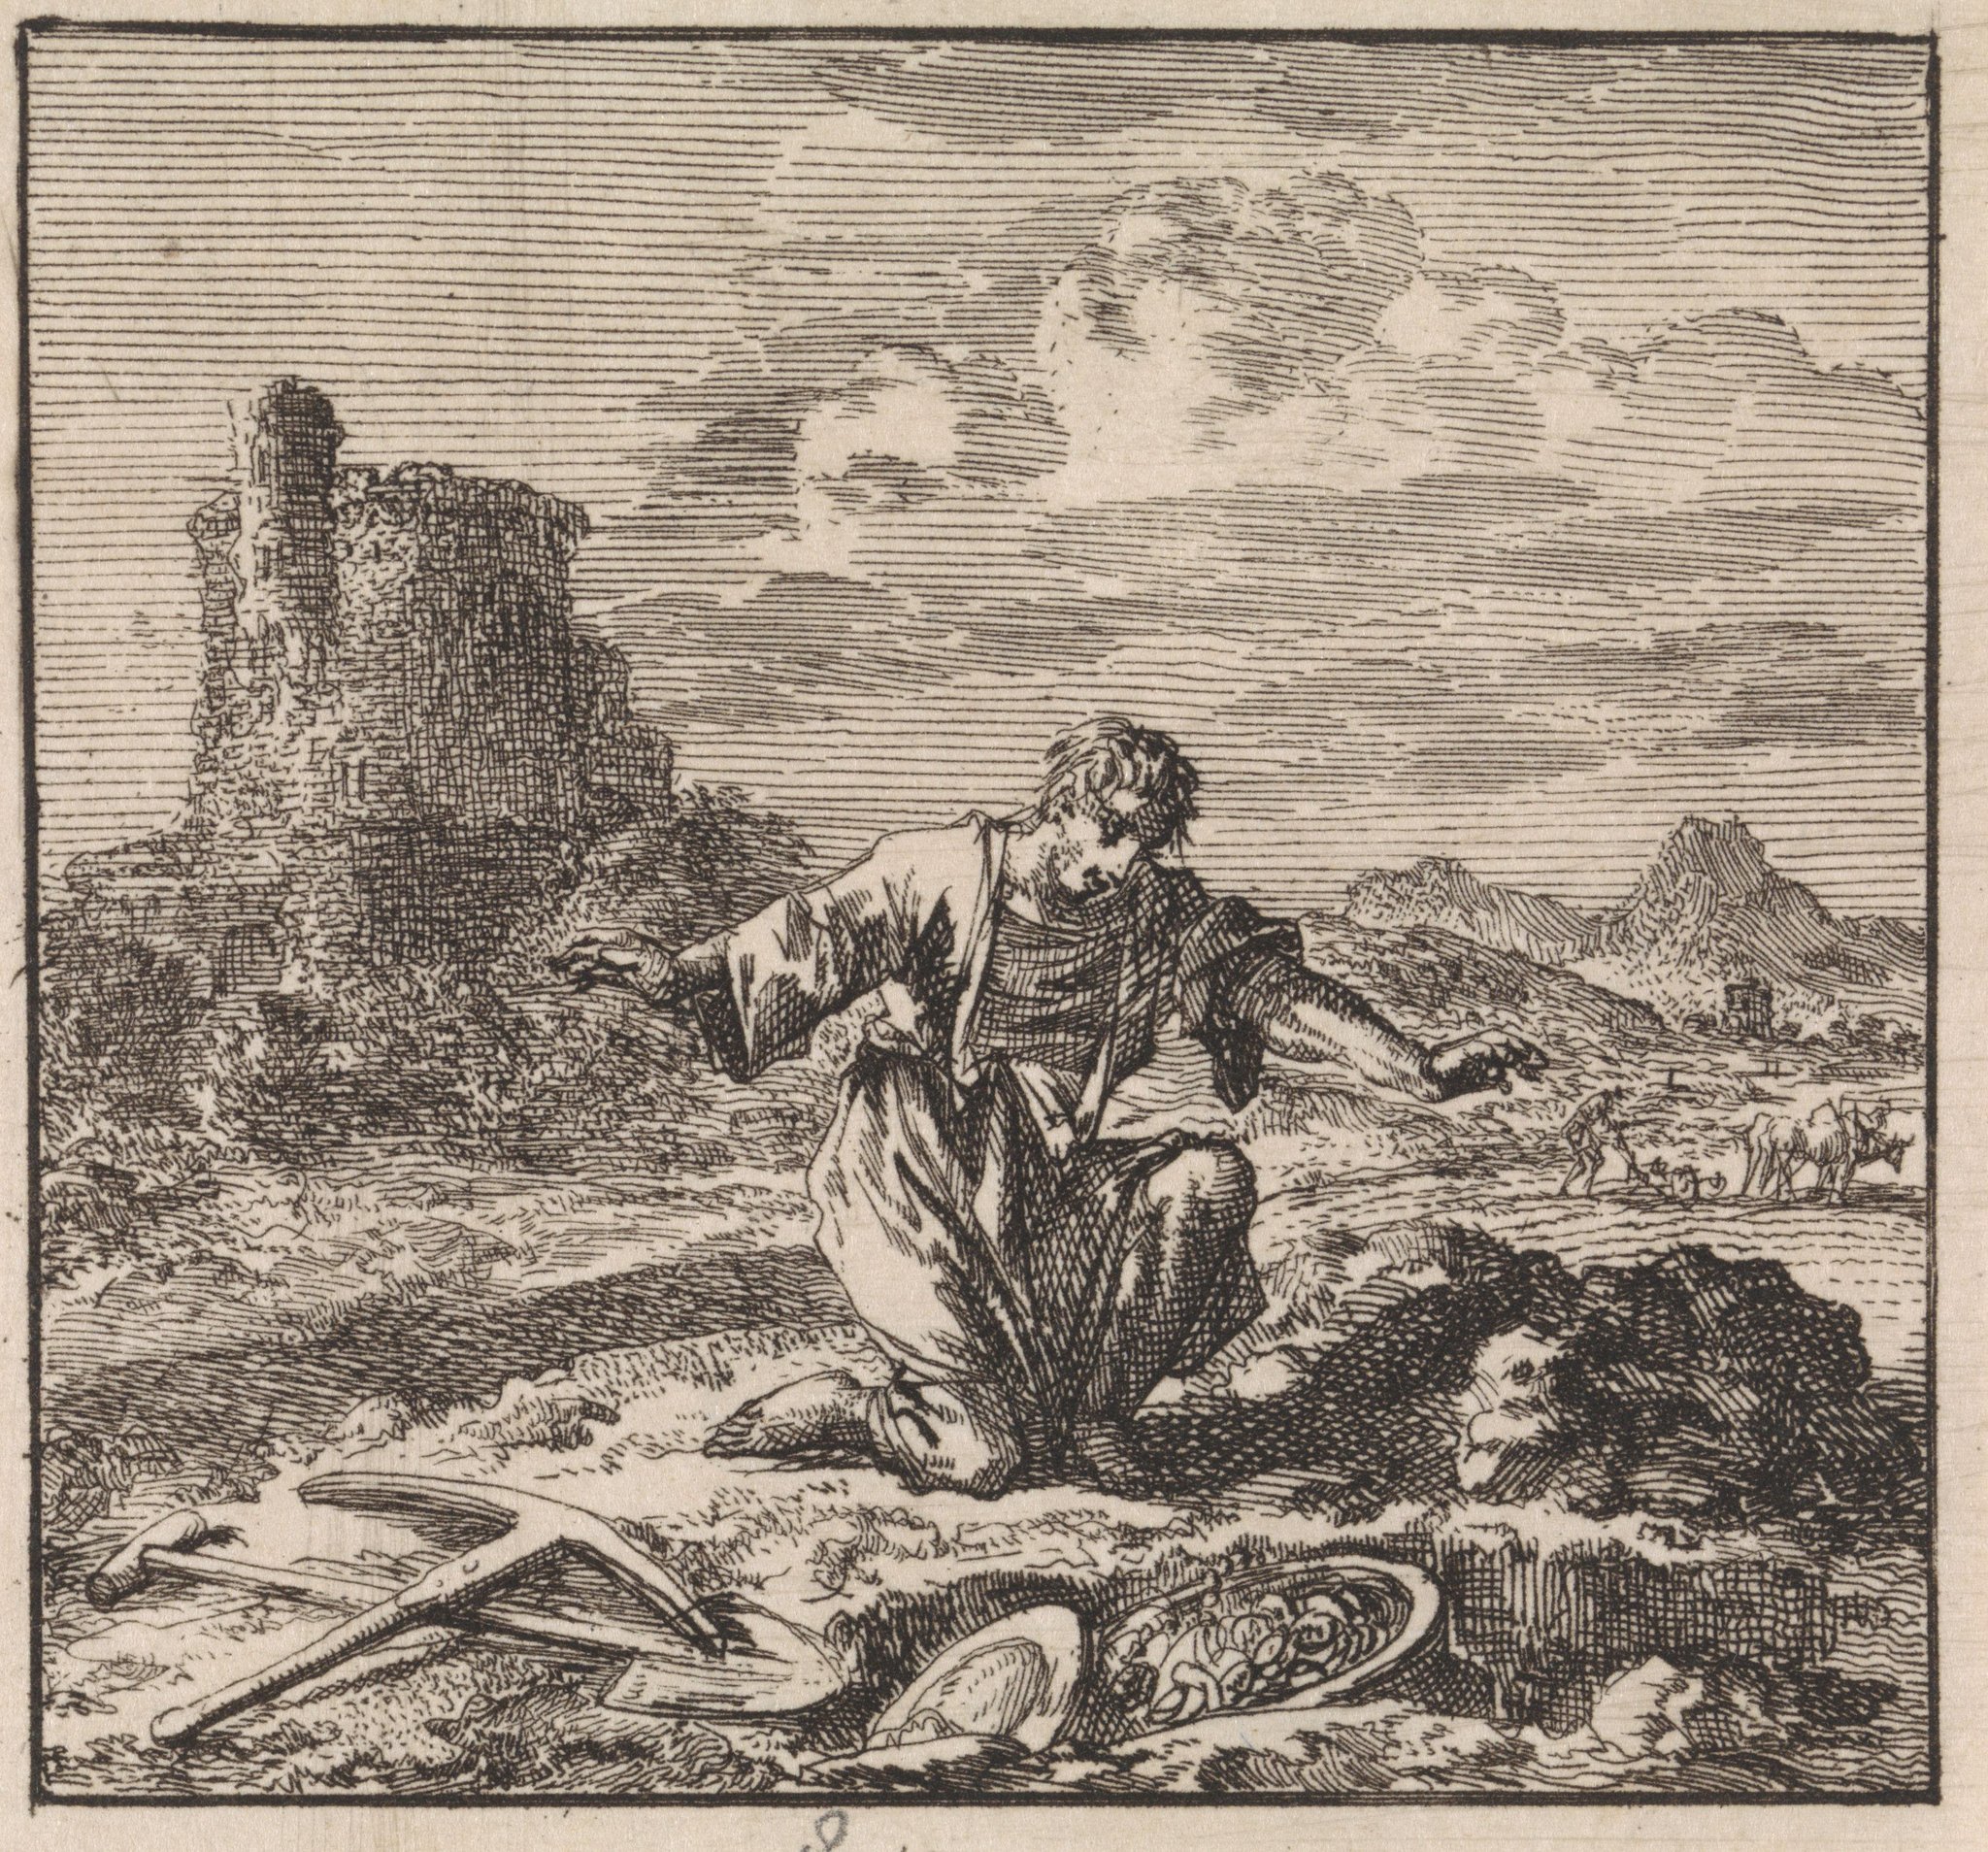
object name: print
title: Het Slecht-schynende Recht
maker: jan luyken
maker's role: draughtsman, print maker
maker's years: 1649-1712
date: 1710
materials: paper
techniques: etching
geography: amsterdam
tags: treasure hunting, goldrush, landscapes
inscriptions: collector's mark: Lugt 2228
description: Proefdruk voor illustratie uit: Luyken, Jan. De onwaardige wereld, vertoond in vyftig zinnebeelden, met godlyke spreuken en stichtelyke verzen. Amsterdam: Pieter Arentsz. II (wed.) en Cornelis van der Sys, 1710, p. 30.